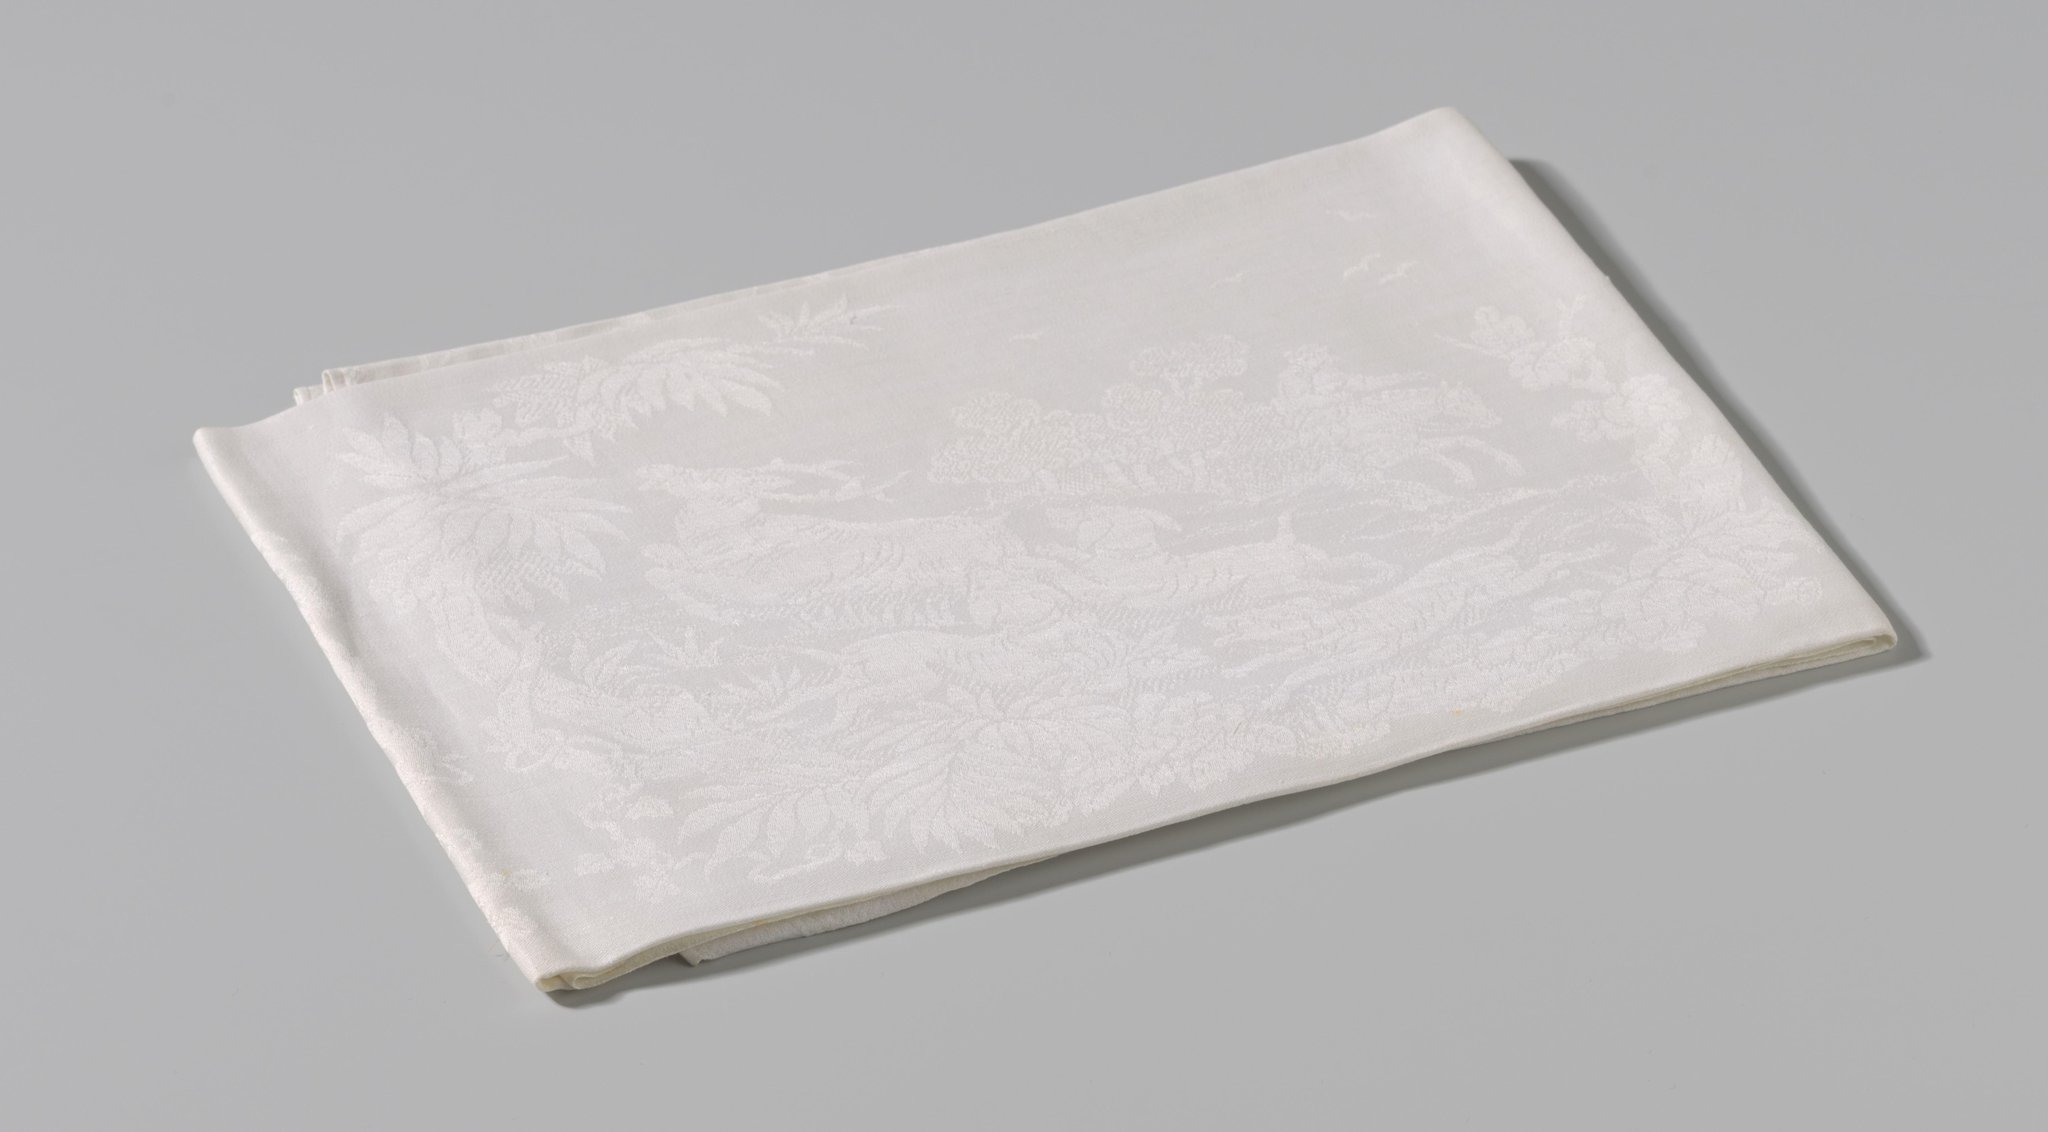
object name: napkin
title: Servet van linnendamast met een wapen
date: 1867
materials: linen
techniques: damask, weave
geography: veghel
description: Servet van linnendamast met het wapen van Schimmelpenninck. Het servet hoort bij elf servetten (BK-1973-216-A t/m BK-1973-216-L) en een tafellaken (BK-1973-215).